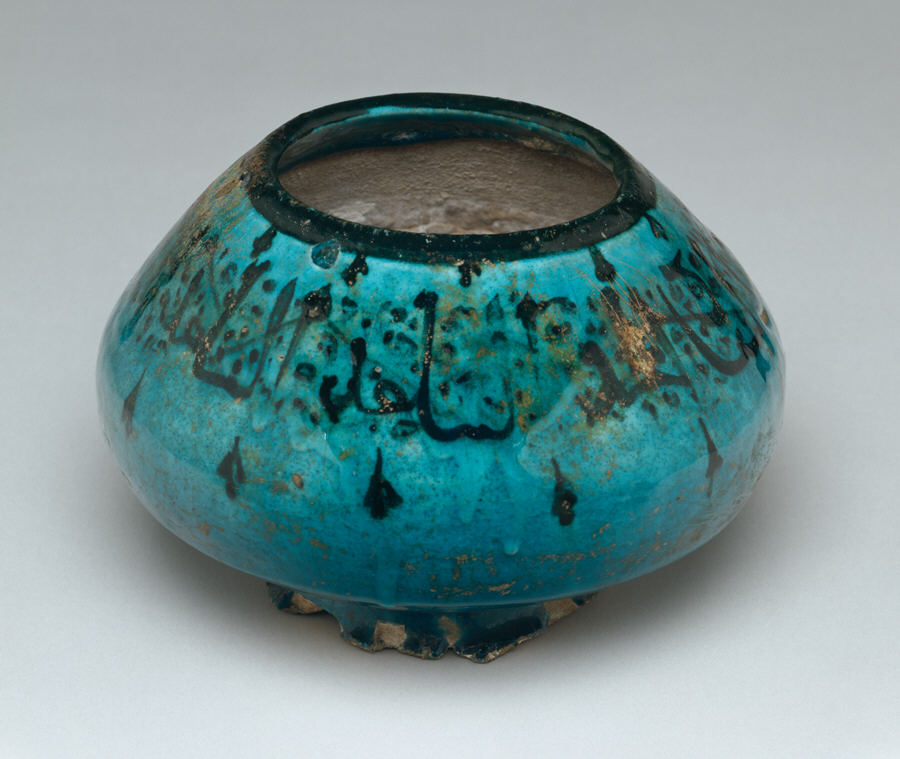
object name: bowl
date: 1201-1300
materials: glaze, stonepaste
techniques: painting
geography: syria